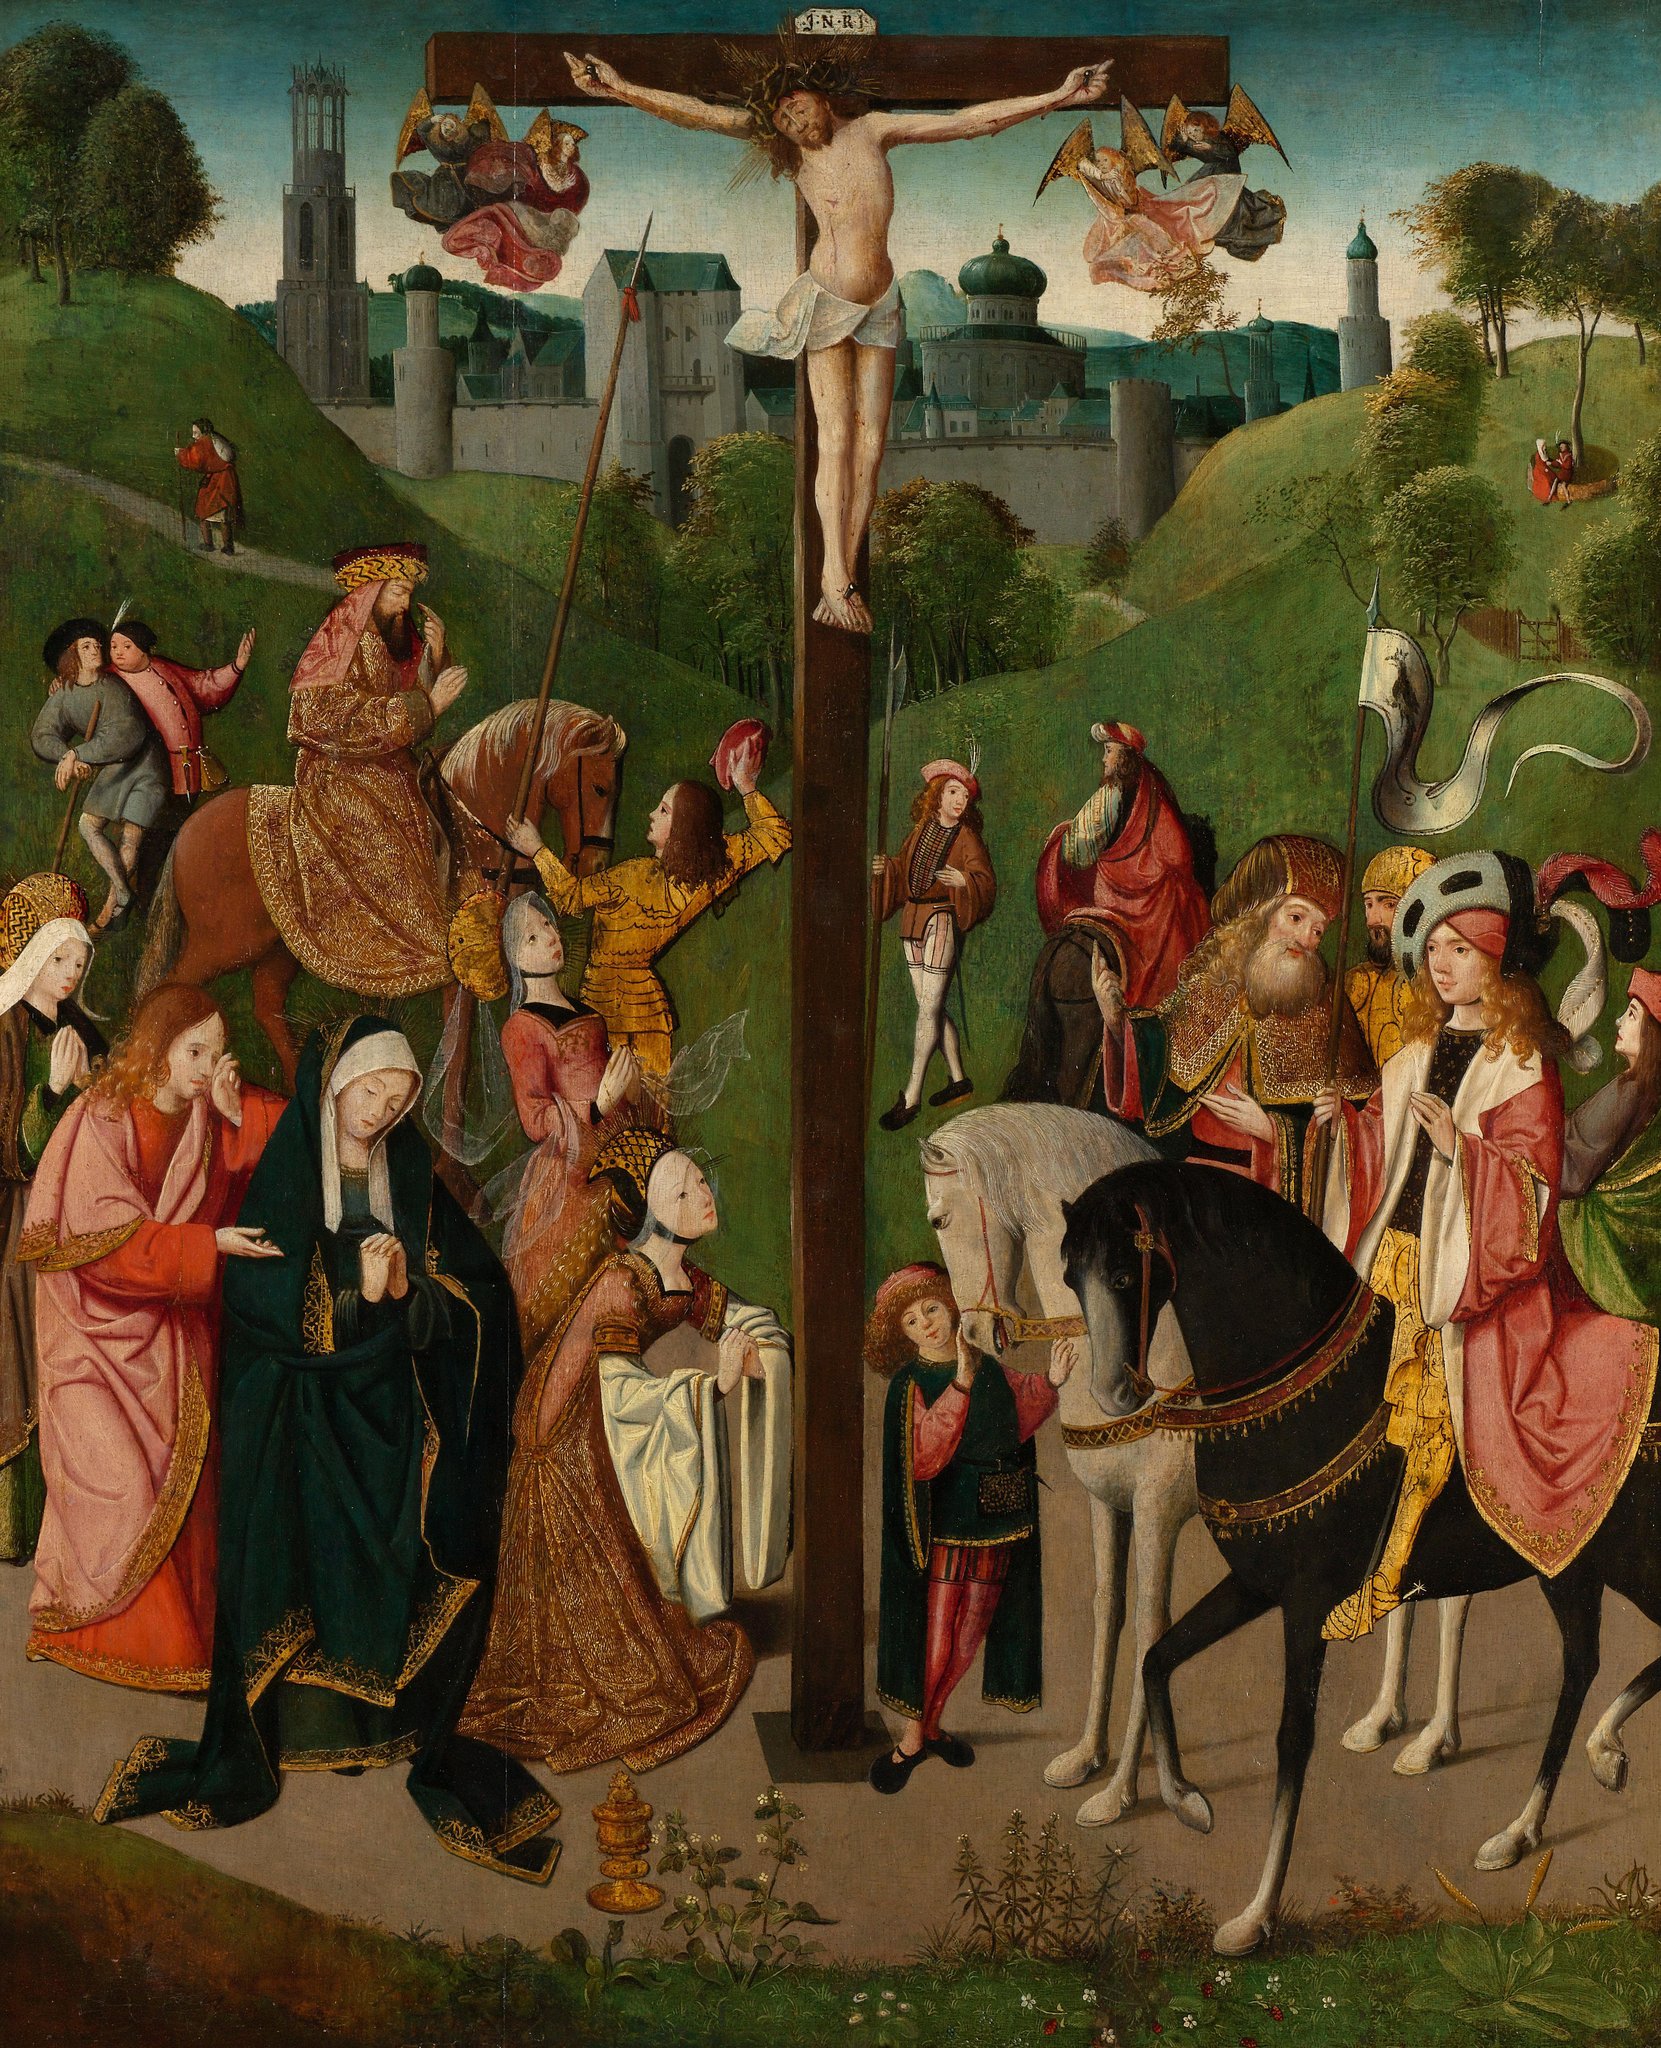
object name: painting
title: The Crucifixion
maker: master of the figdor deposition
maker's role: painter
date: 1505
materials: oil, panel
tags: crucified christ with mary, john, and mary magdalene, the centurion confessing his belief in christ; sometimes the soldiers do the same, utrecht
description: The fantasy clothing of the foreground figures situates the biblical story in a distant past. The painter also larded this crucifixion scene with elements from his own world: the tall tower in the walled town – Jerusalem – in the background is almost certainly the cathedral of Utrecht. Not everyone follows the story of salvation in the middle ground: in the hills at the left an old traveller continues on his way while an amorous couple dally at the right.